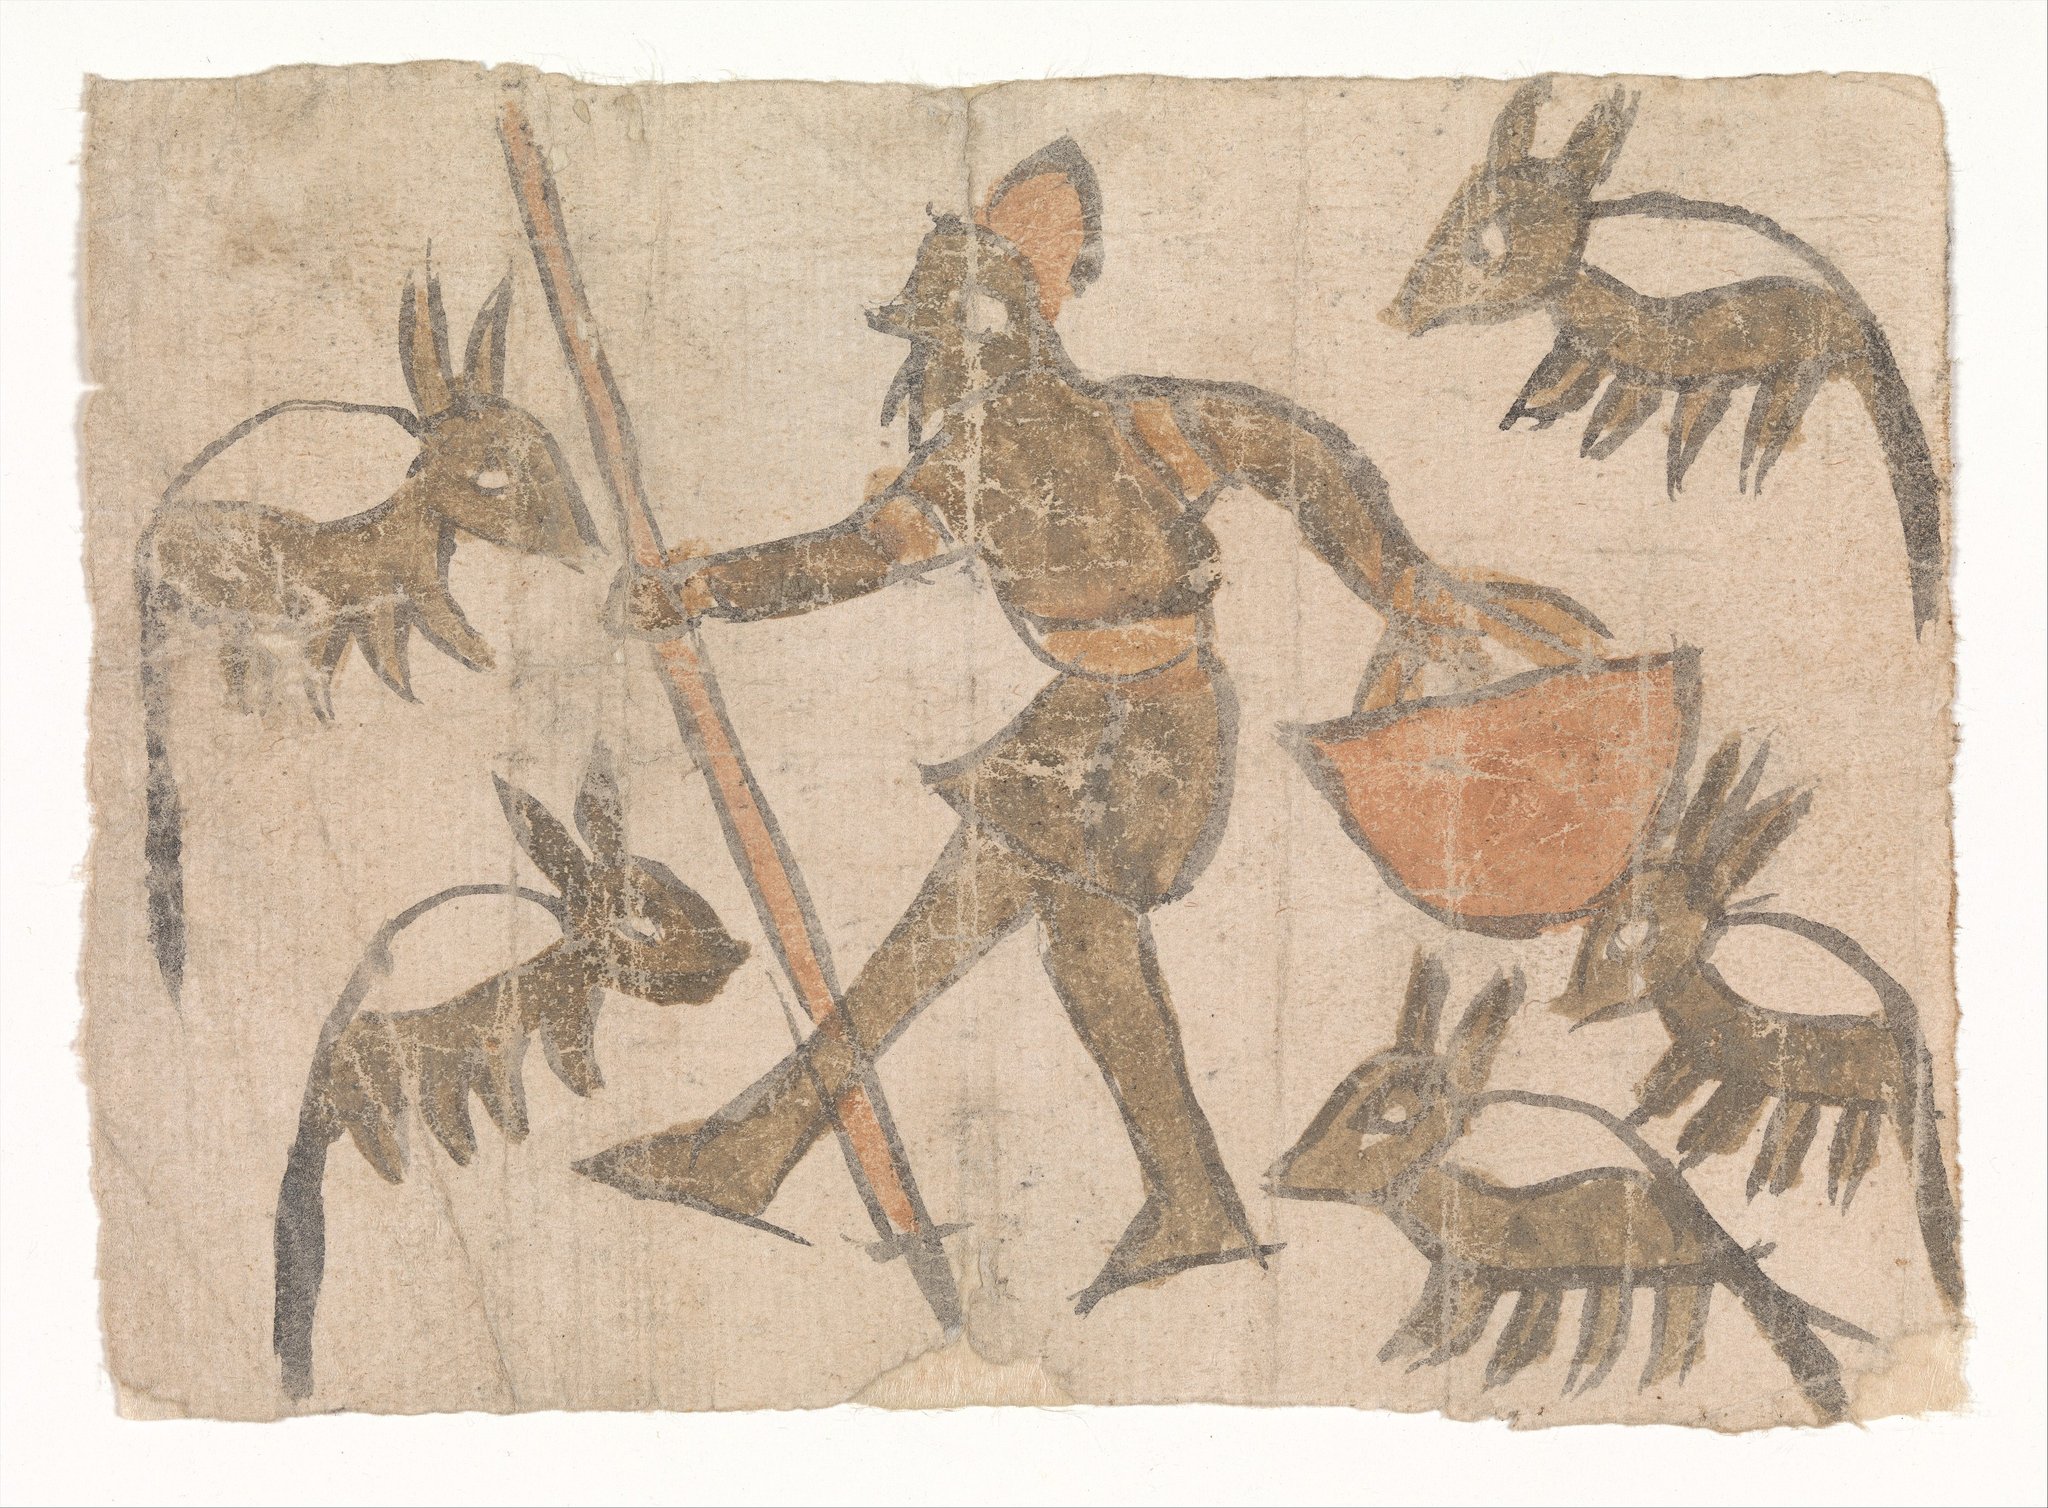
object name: illustrated album leaf or single work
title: Herdsman and his Flock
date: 1151-1200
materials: paper, watercolor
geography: egypt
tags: animals,men